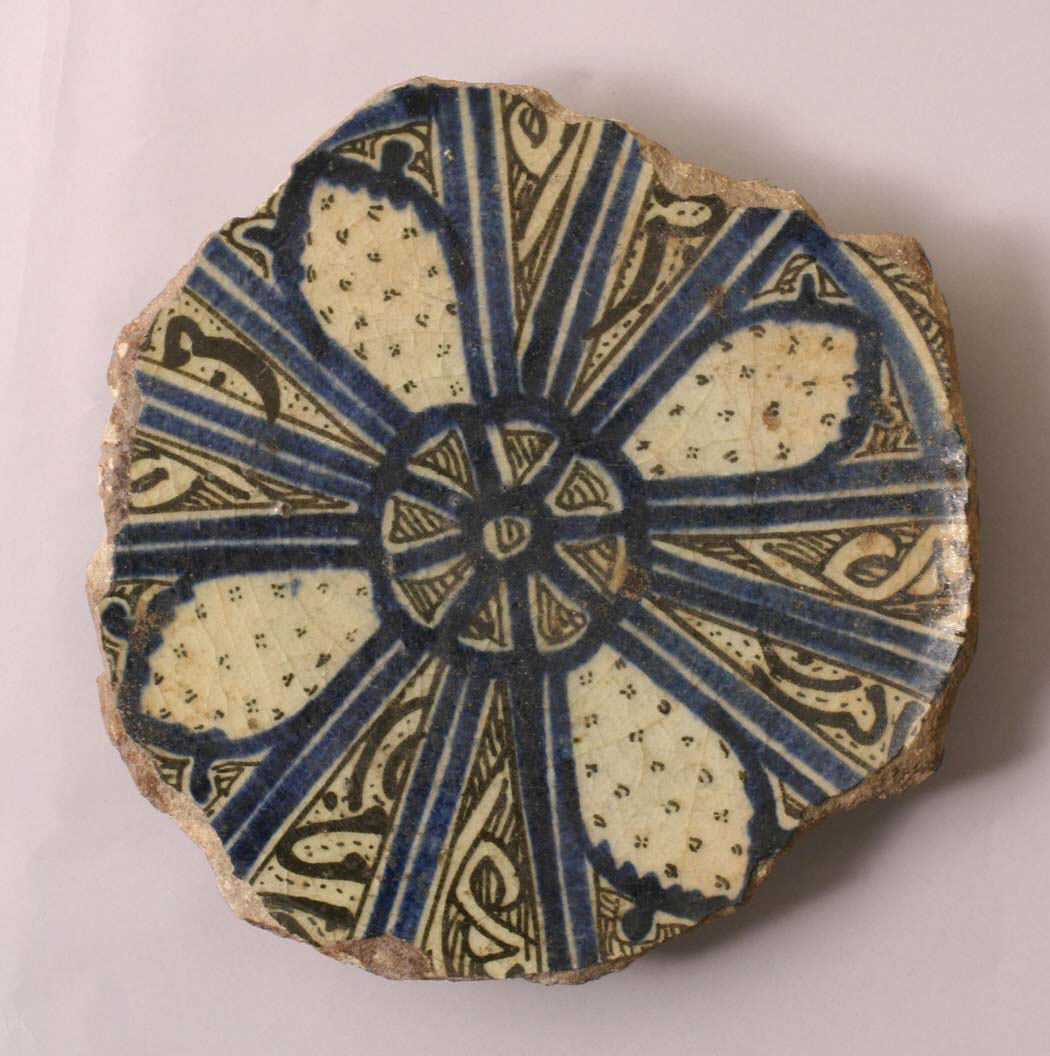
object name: ceramic fragment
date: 1301-1400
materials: glaze, stonepaste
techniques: painting, polychrome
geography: syria